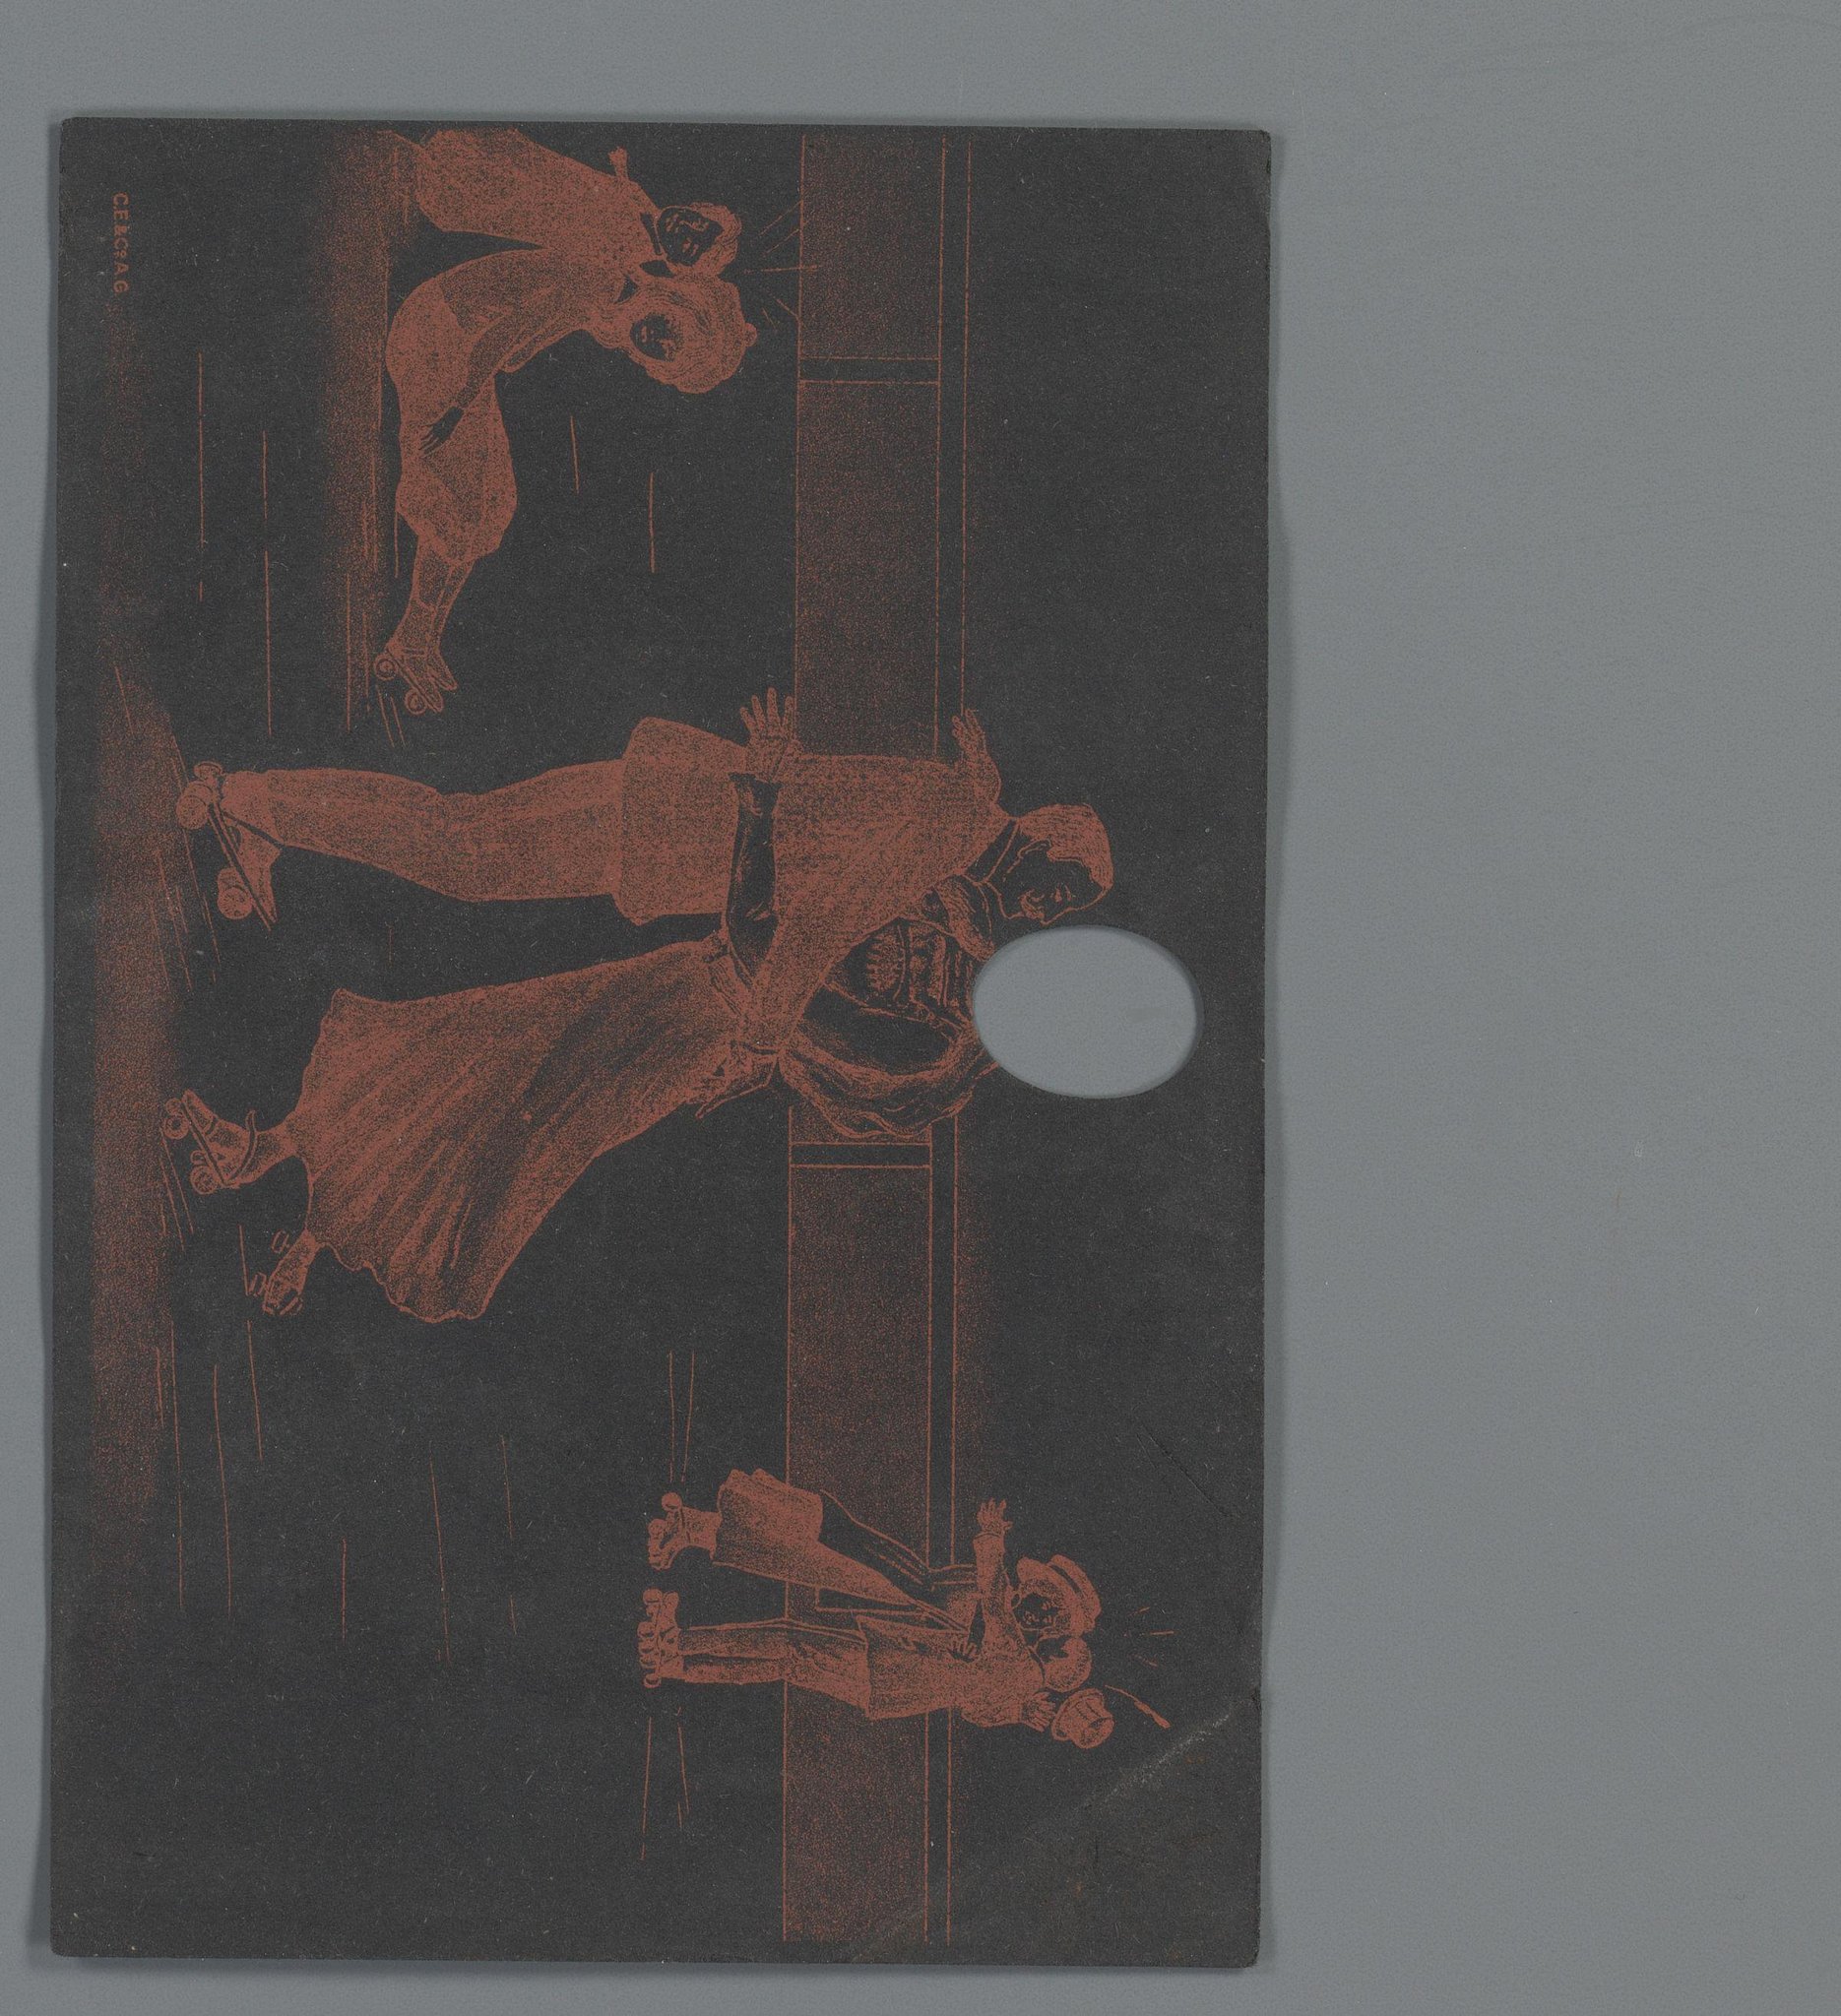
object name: print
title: Rolschaatsende paren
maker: carlernco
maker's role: publisher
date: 1900-1930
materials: paper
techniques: lithograph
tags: roller-skating, roller-skates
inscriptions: inscription: ‘C.E. & Co. AG.’